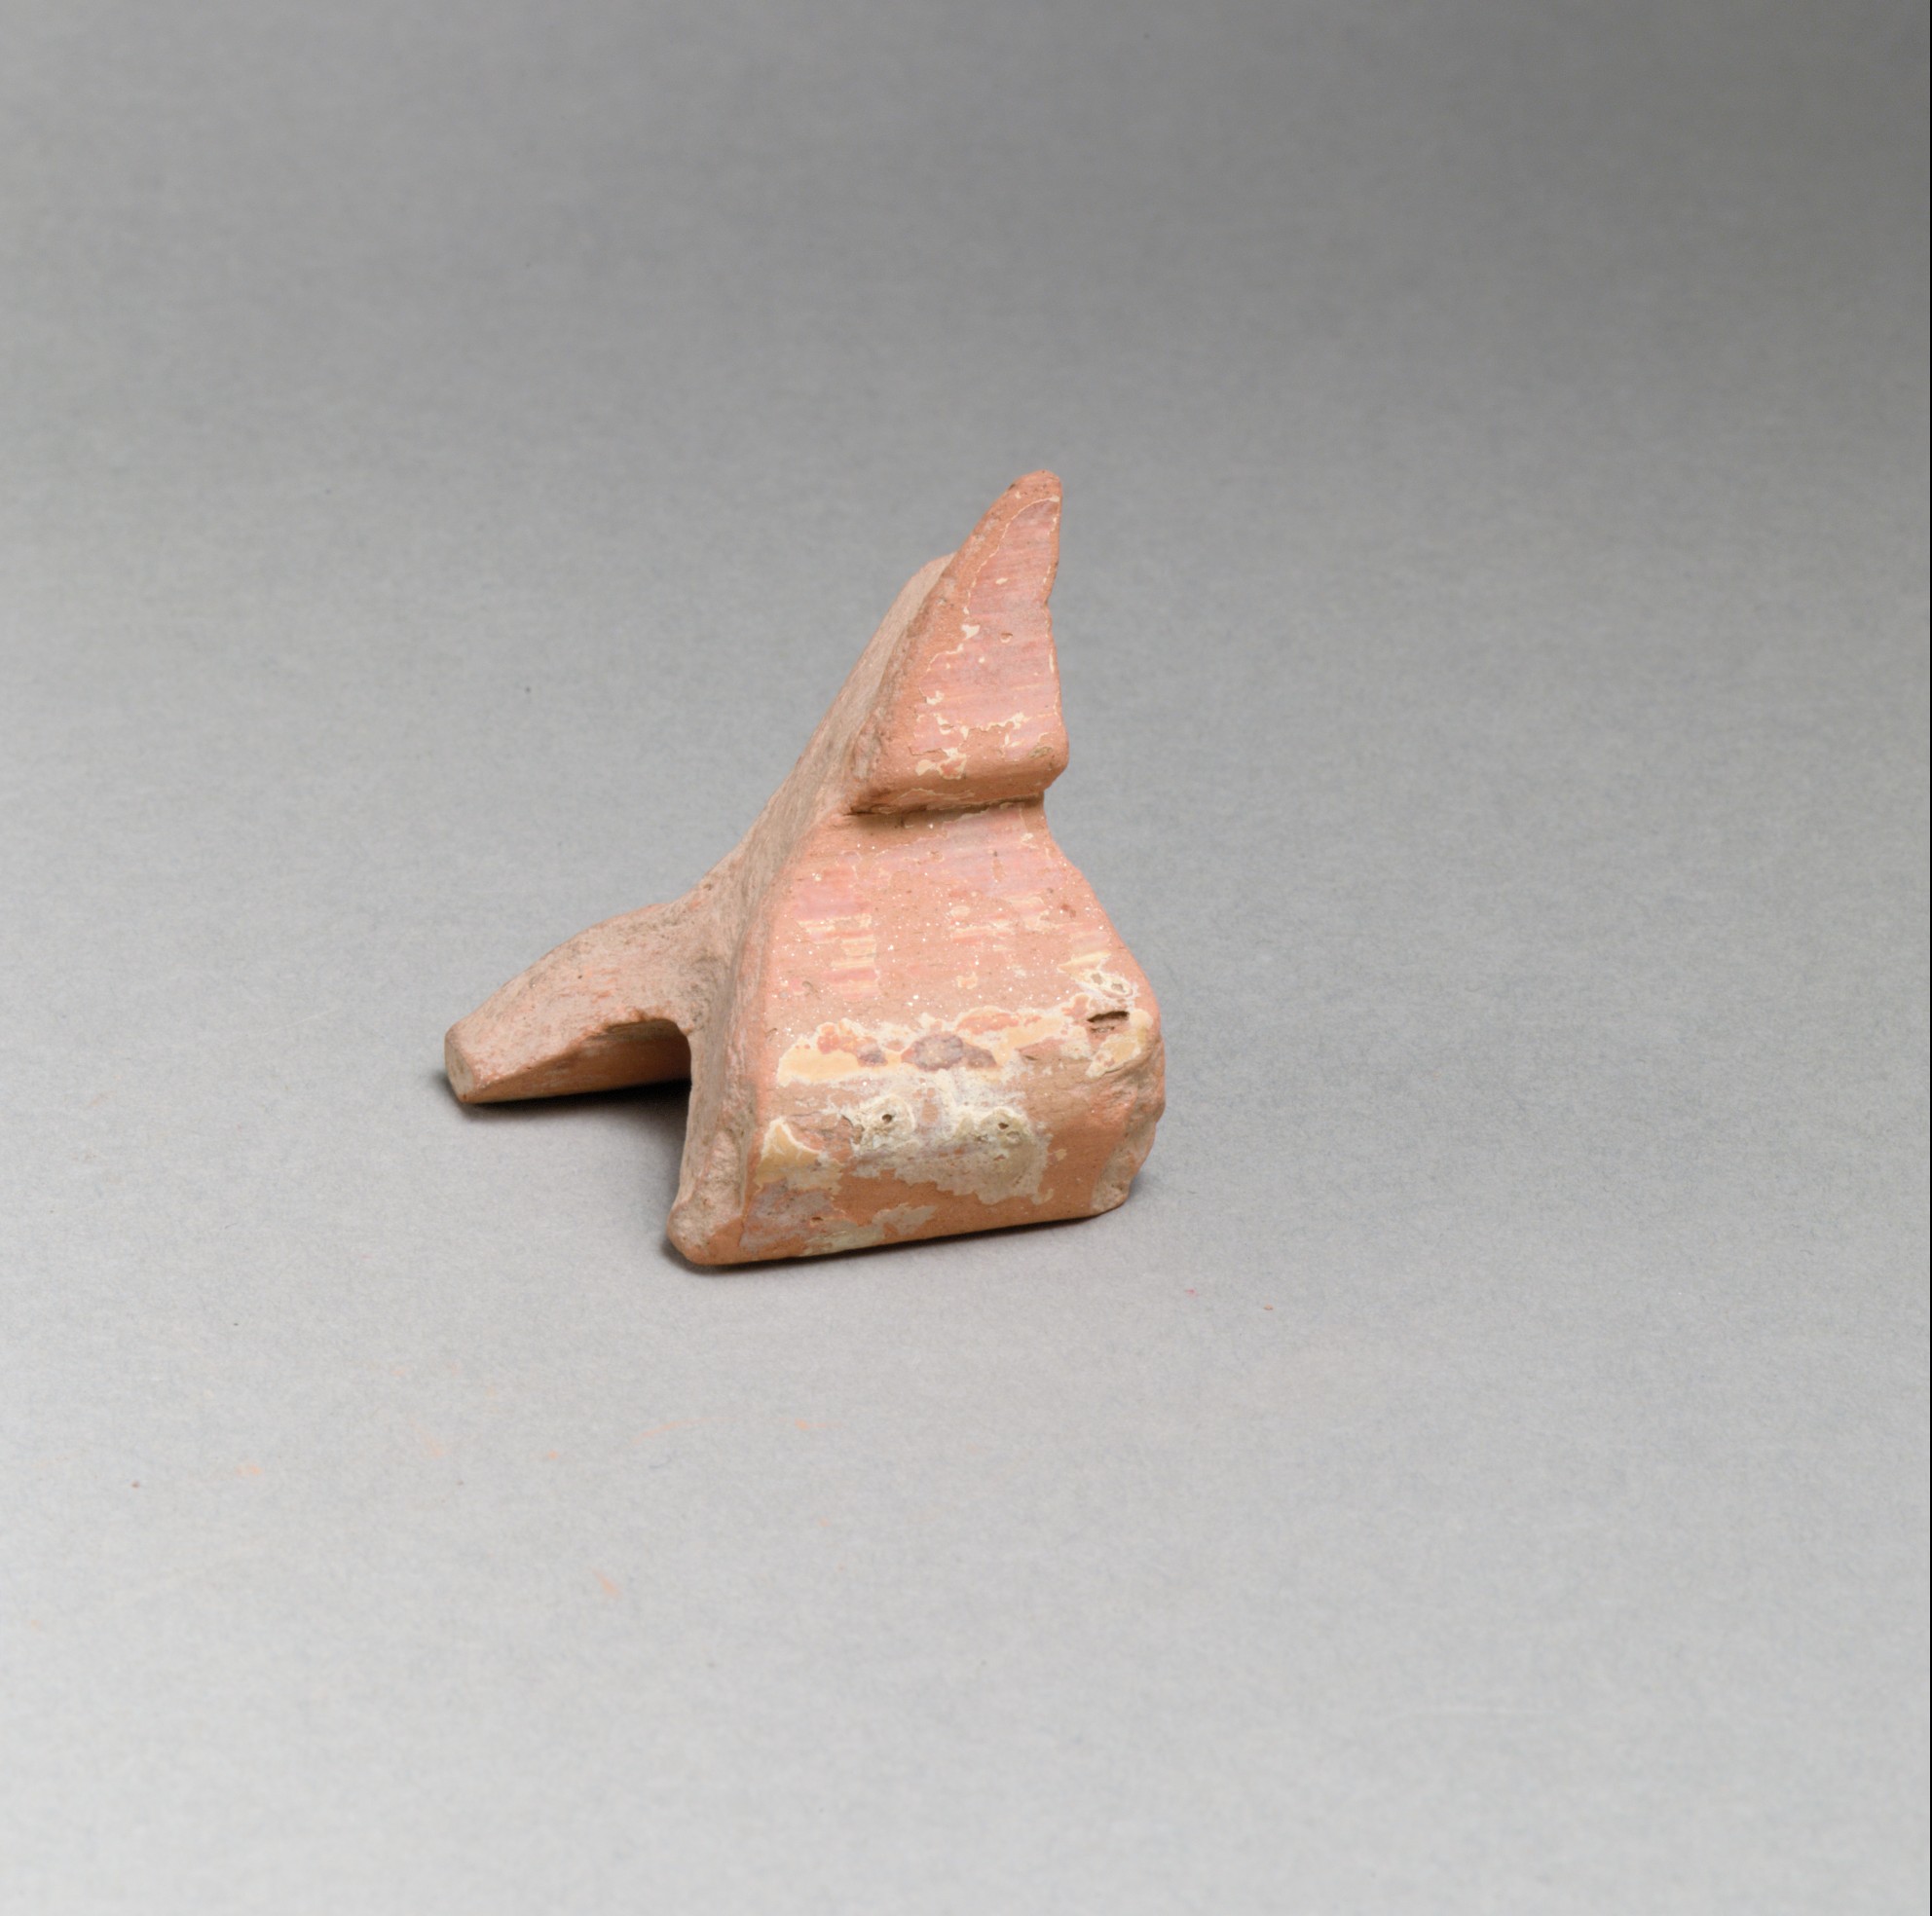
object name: vase fragment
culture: greek or lydian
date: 900-30 BCE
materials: terracotta